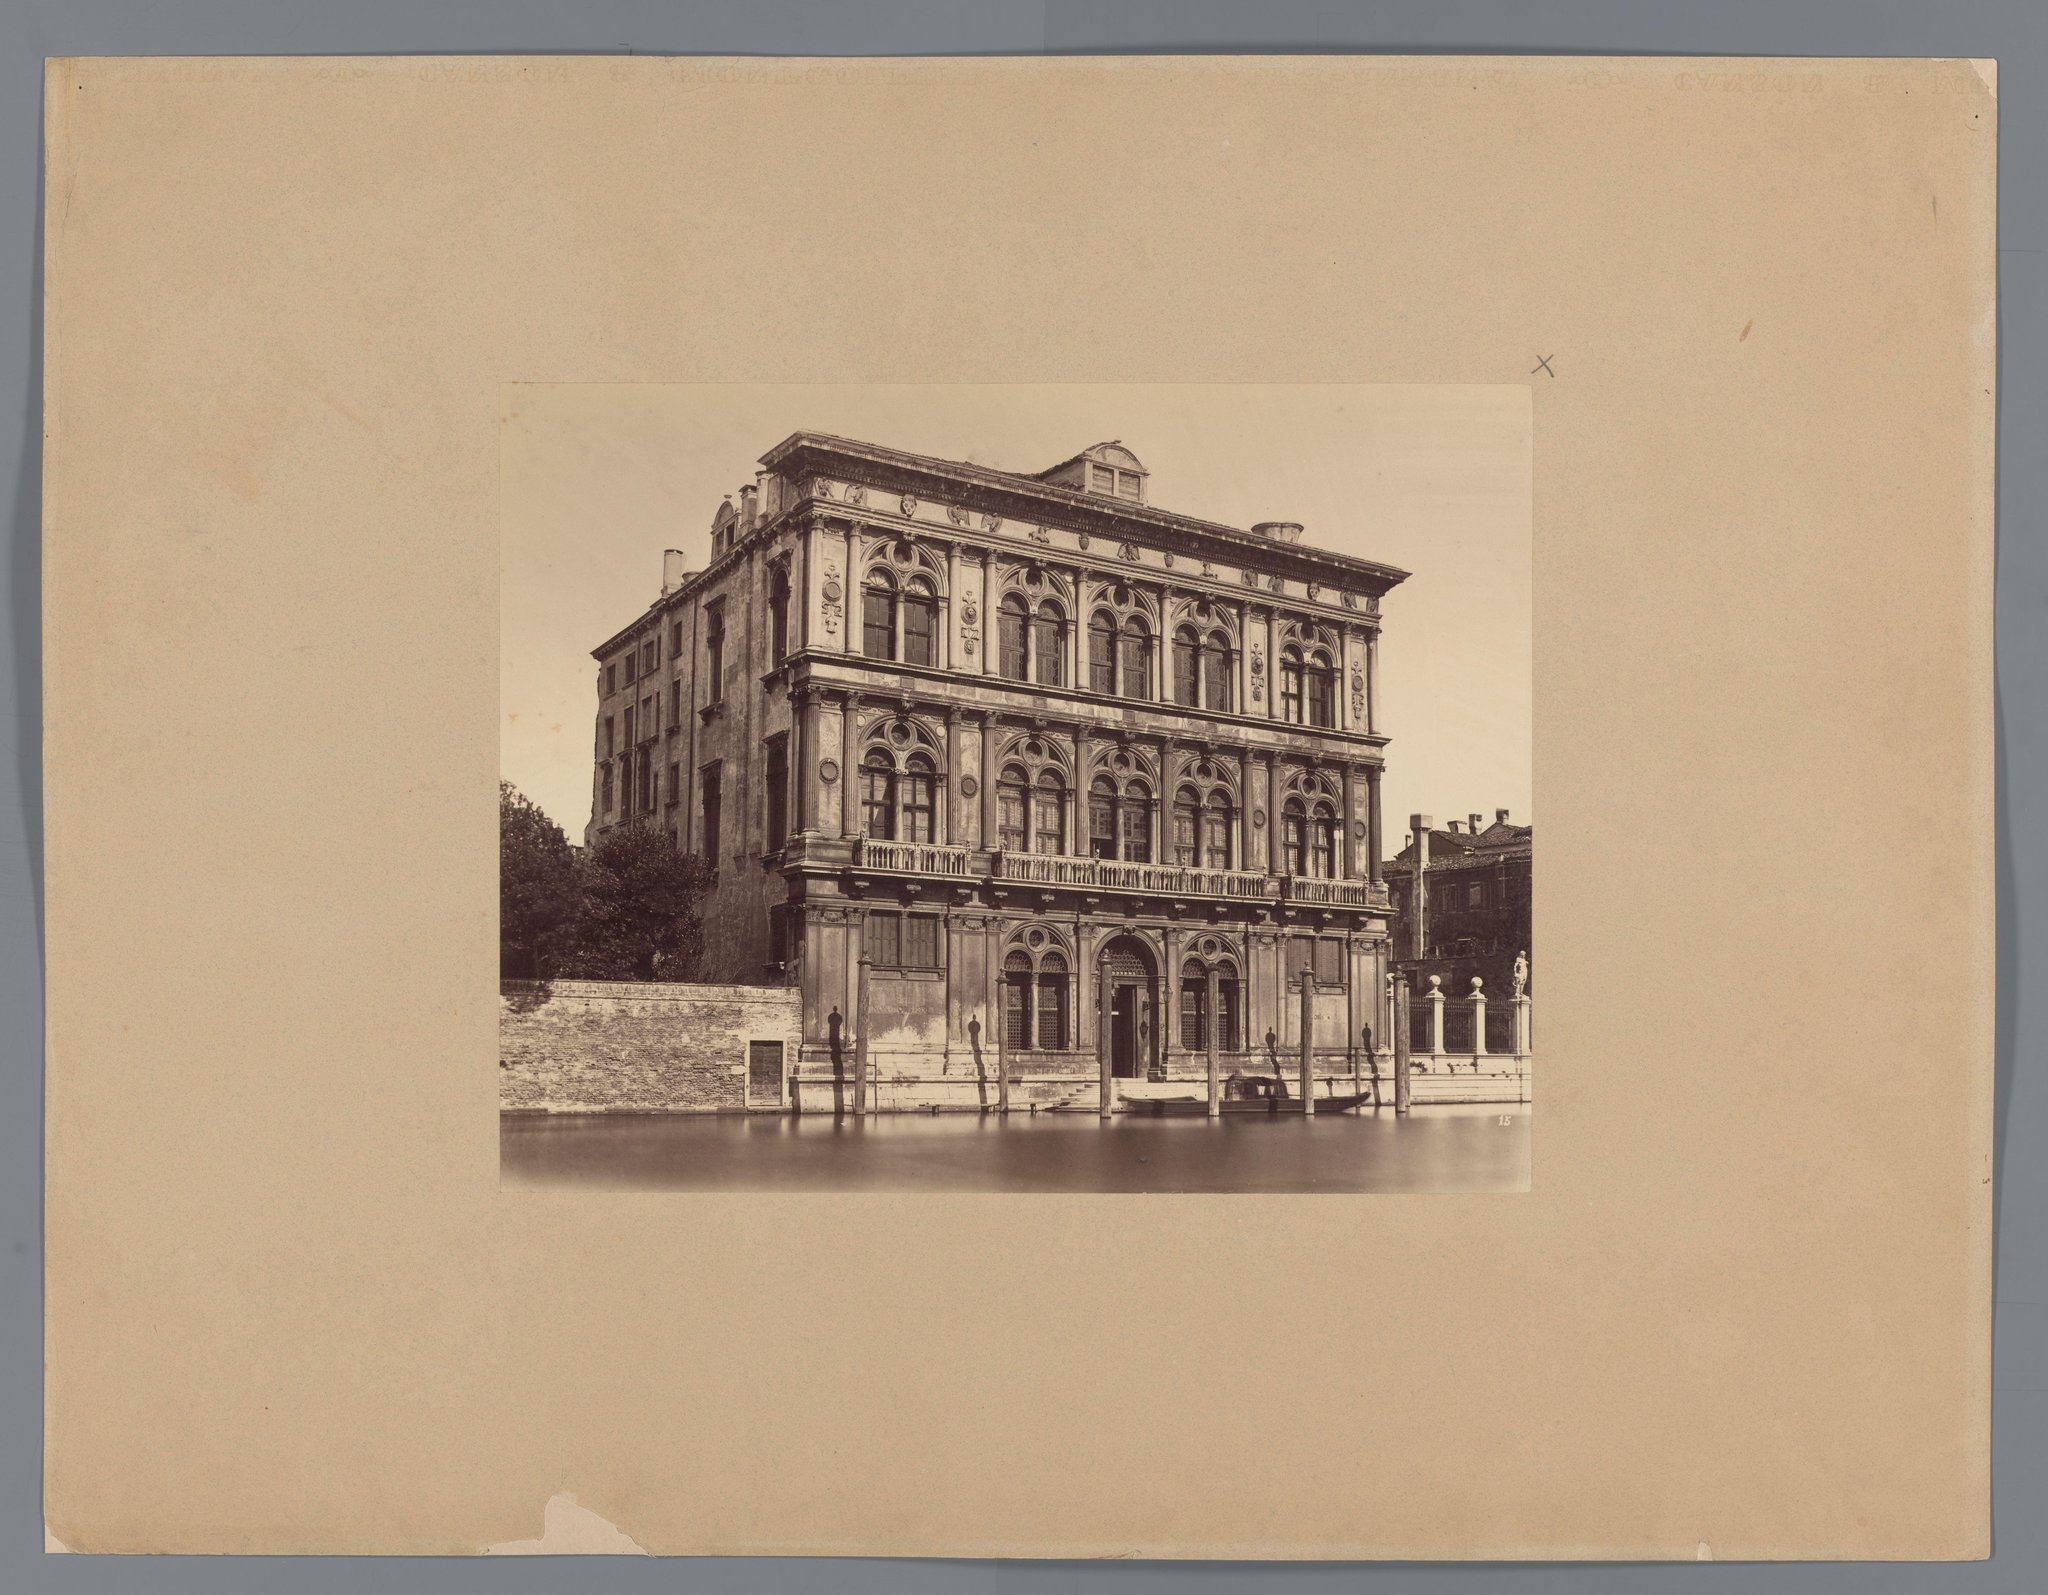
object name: photograph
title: Gezicht op het Palazzo Vendramin Calergi aan het Canal Grande te Venetië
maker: carlo naya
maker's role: fotograaf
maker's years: 1816-1882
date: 1880-1900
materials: cardboard, paper, photographic support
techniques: albumen print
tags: canal grande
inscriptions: : ‘15’